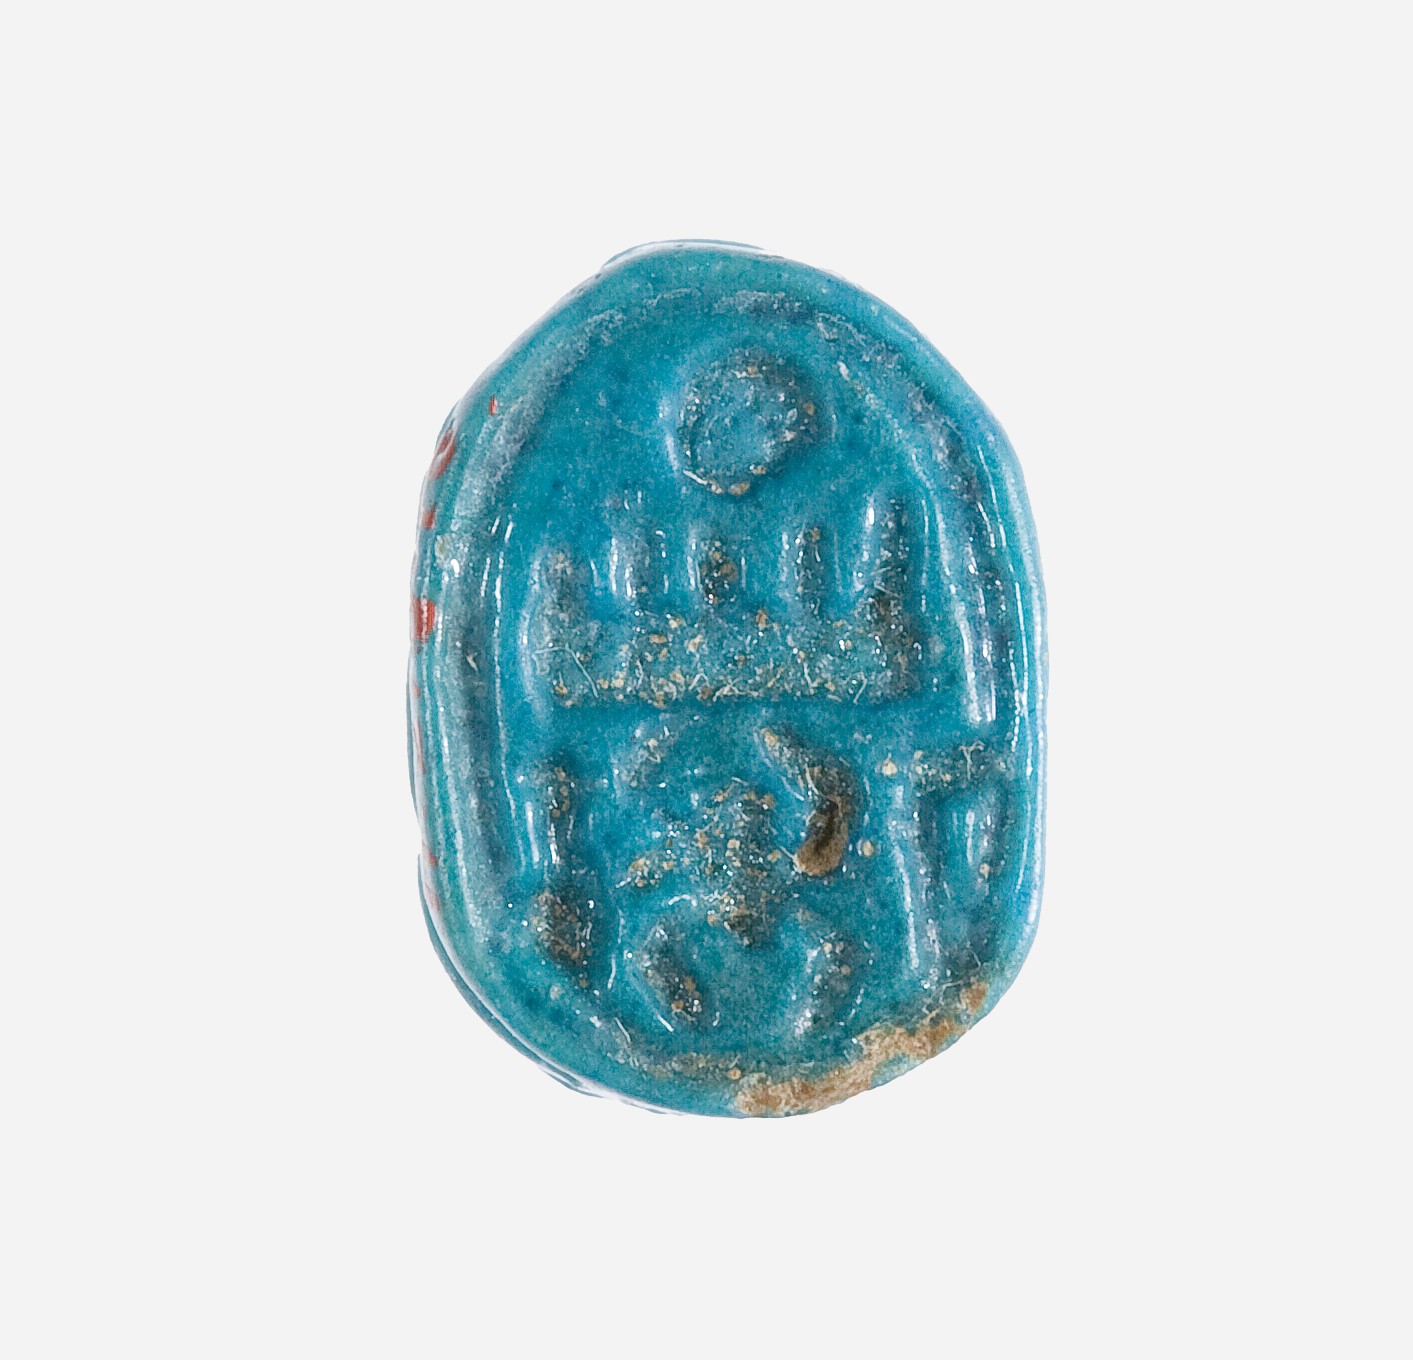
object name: scarab, thutmose iii, menkheperre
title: Scarab Inscribed with the Throne Name of Thutmose III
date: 1390-1352 BCE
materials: faience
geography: egypt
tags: scarabs